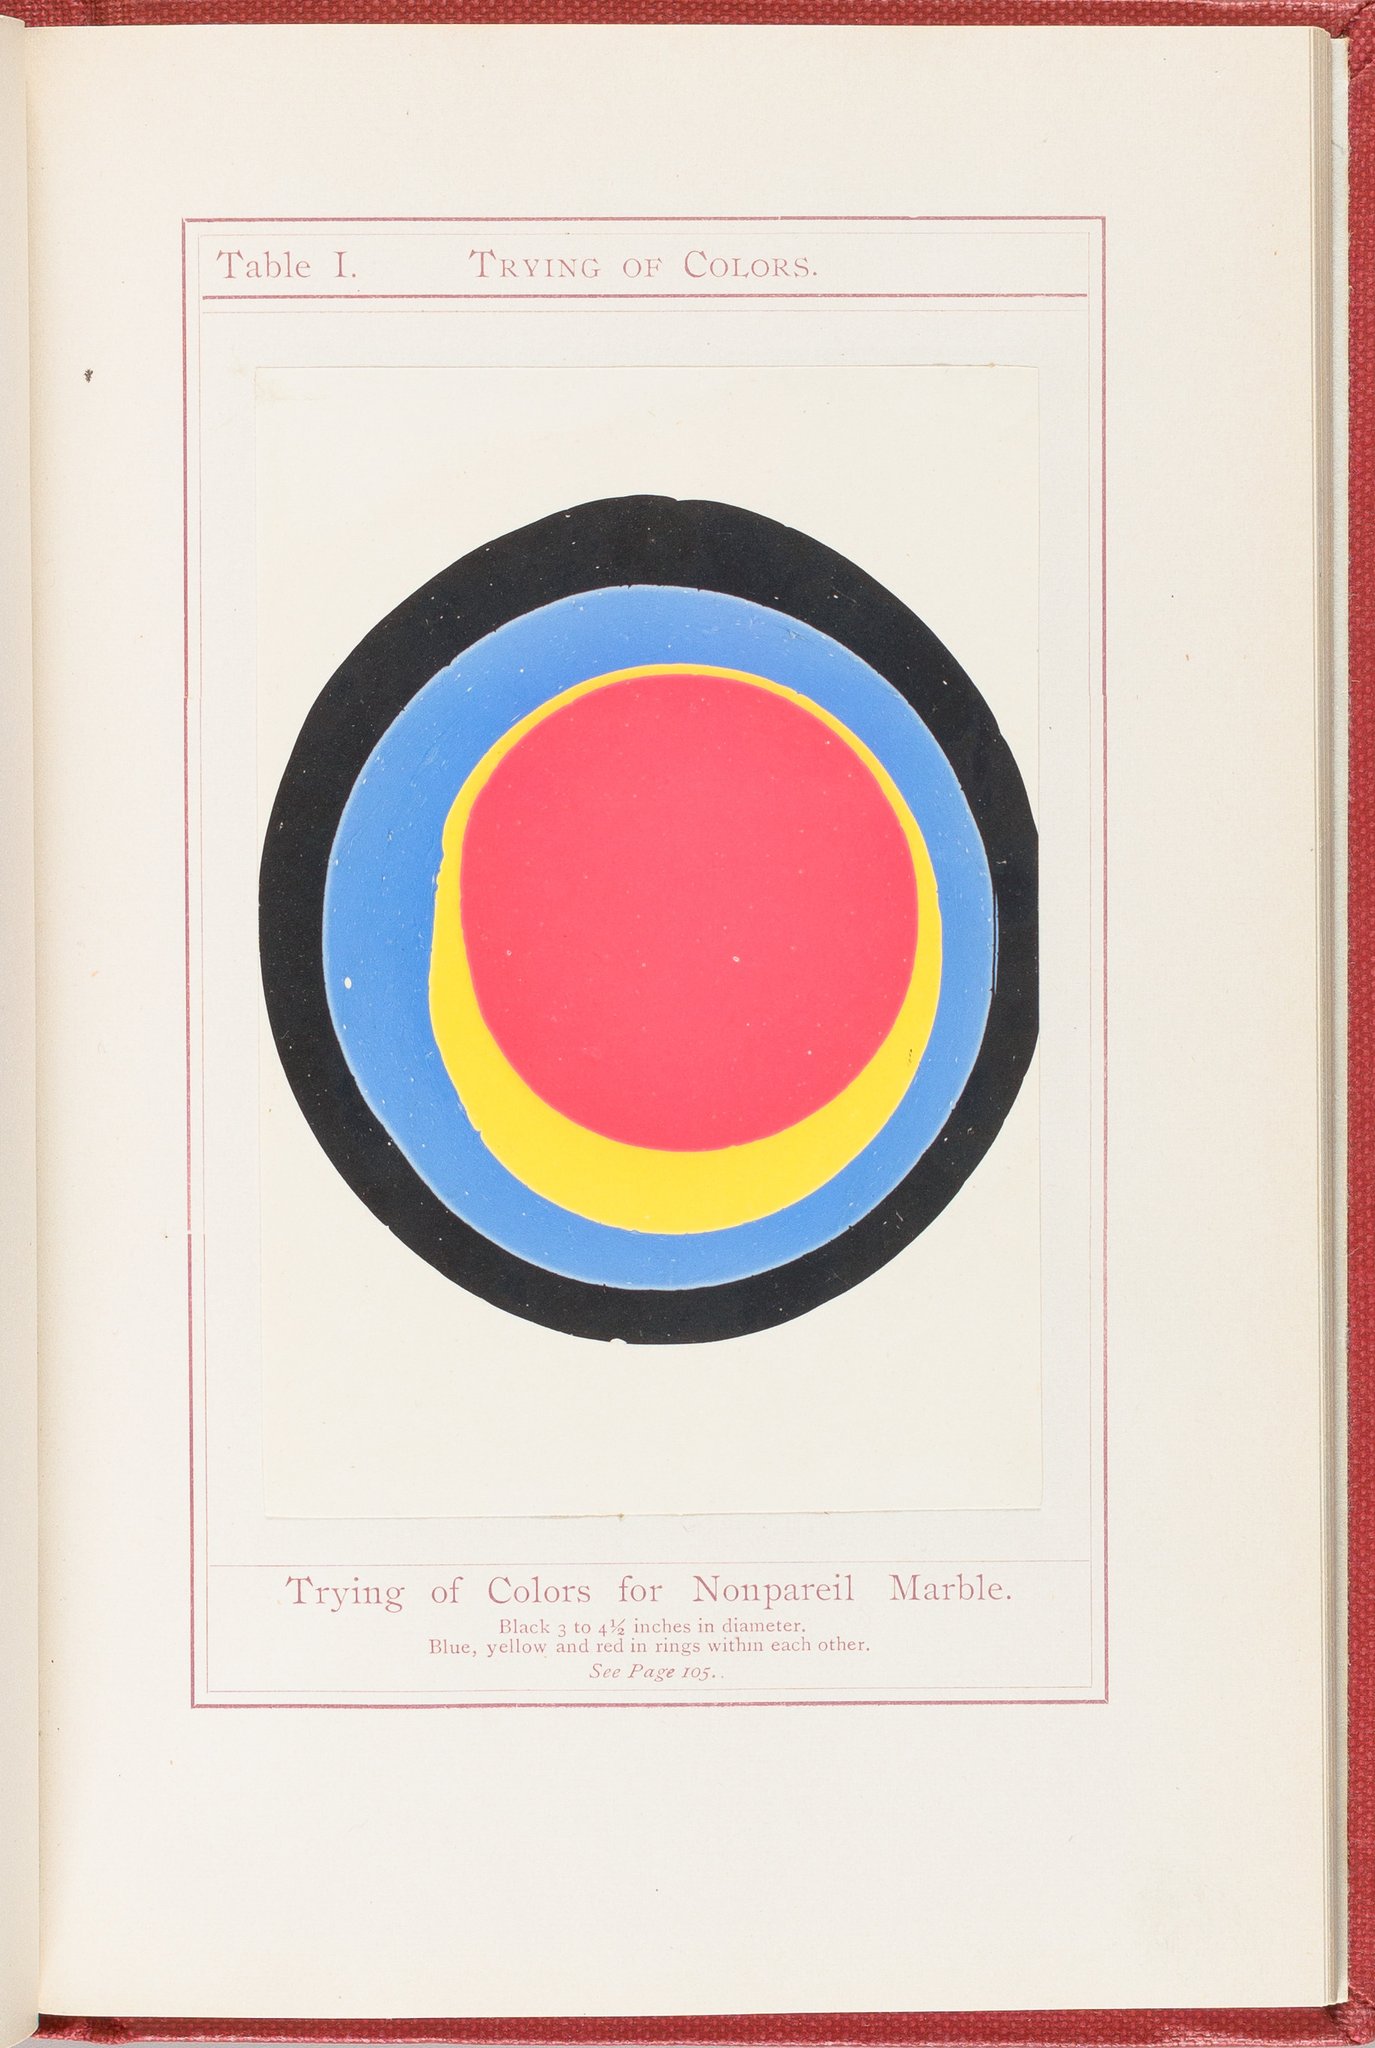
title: The progress of the marbling art, from technical scientific principles : with a supplement on the decoration of book edges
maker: josef halfer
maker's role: author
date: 1893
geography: united states